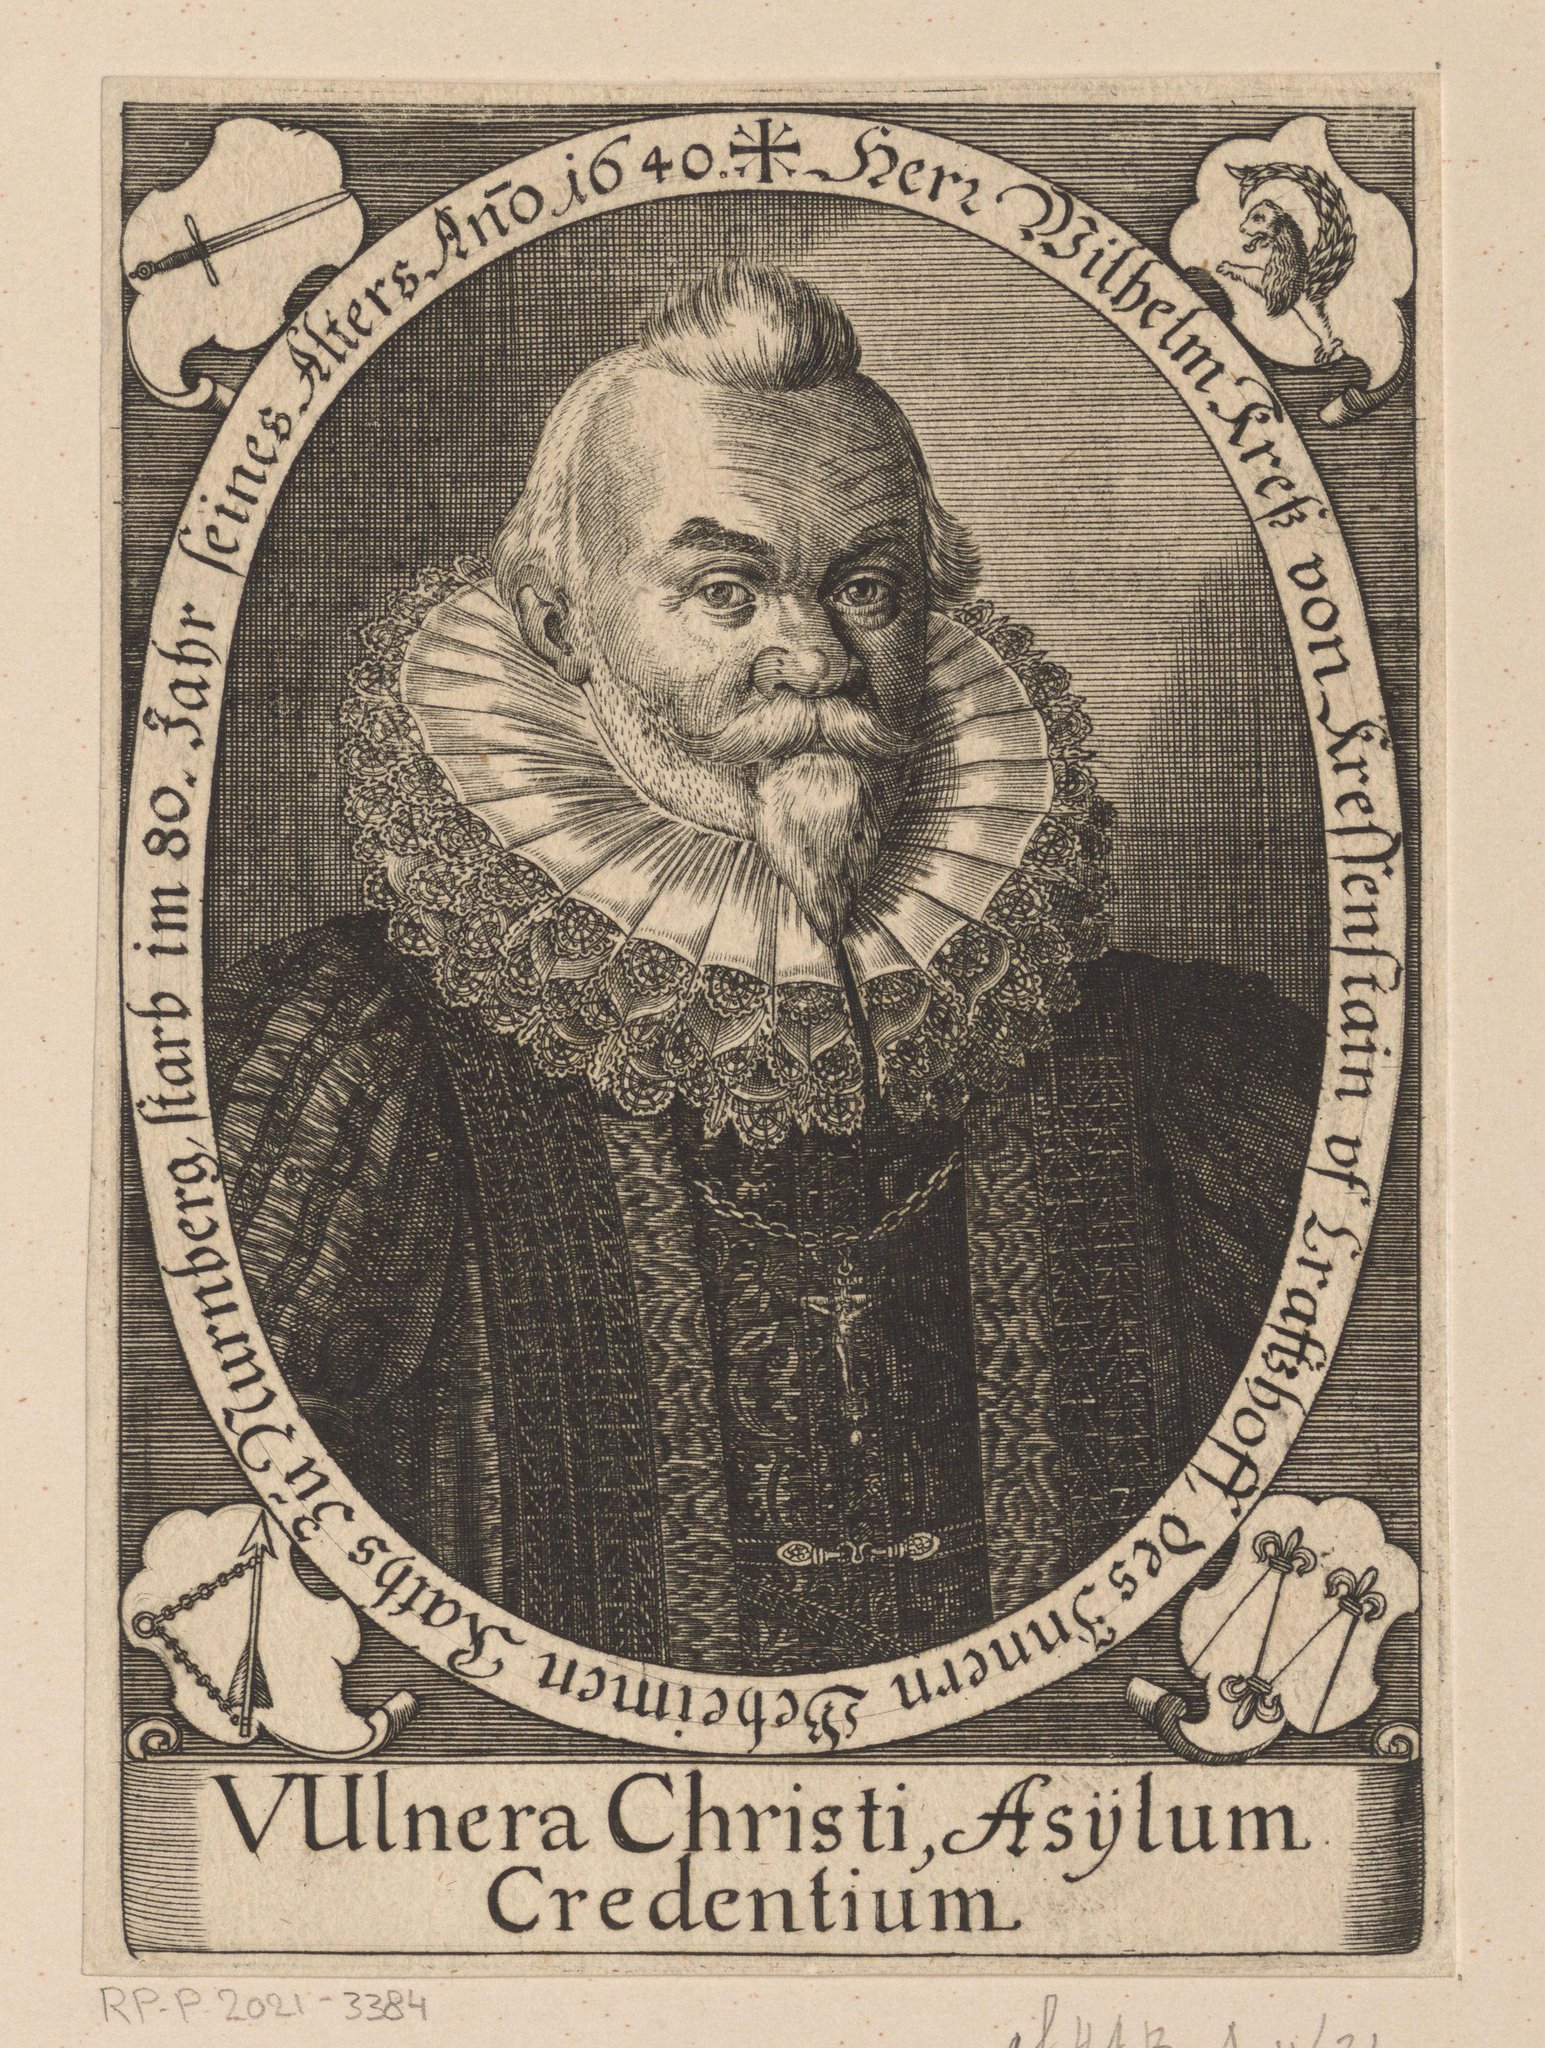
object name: print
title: Portret van Wilhelm Kress von Kressenstein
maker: Anonymous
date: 1640-1699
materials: paper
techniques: engraving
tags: historical persons